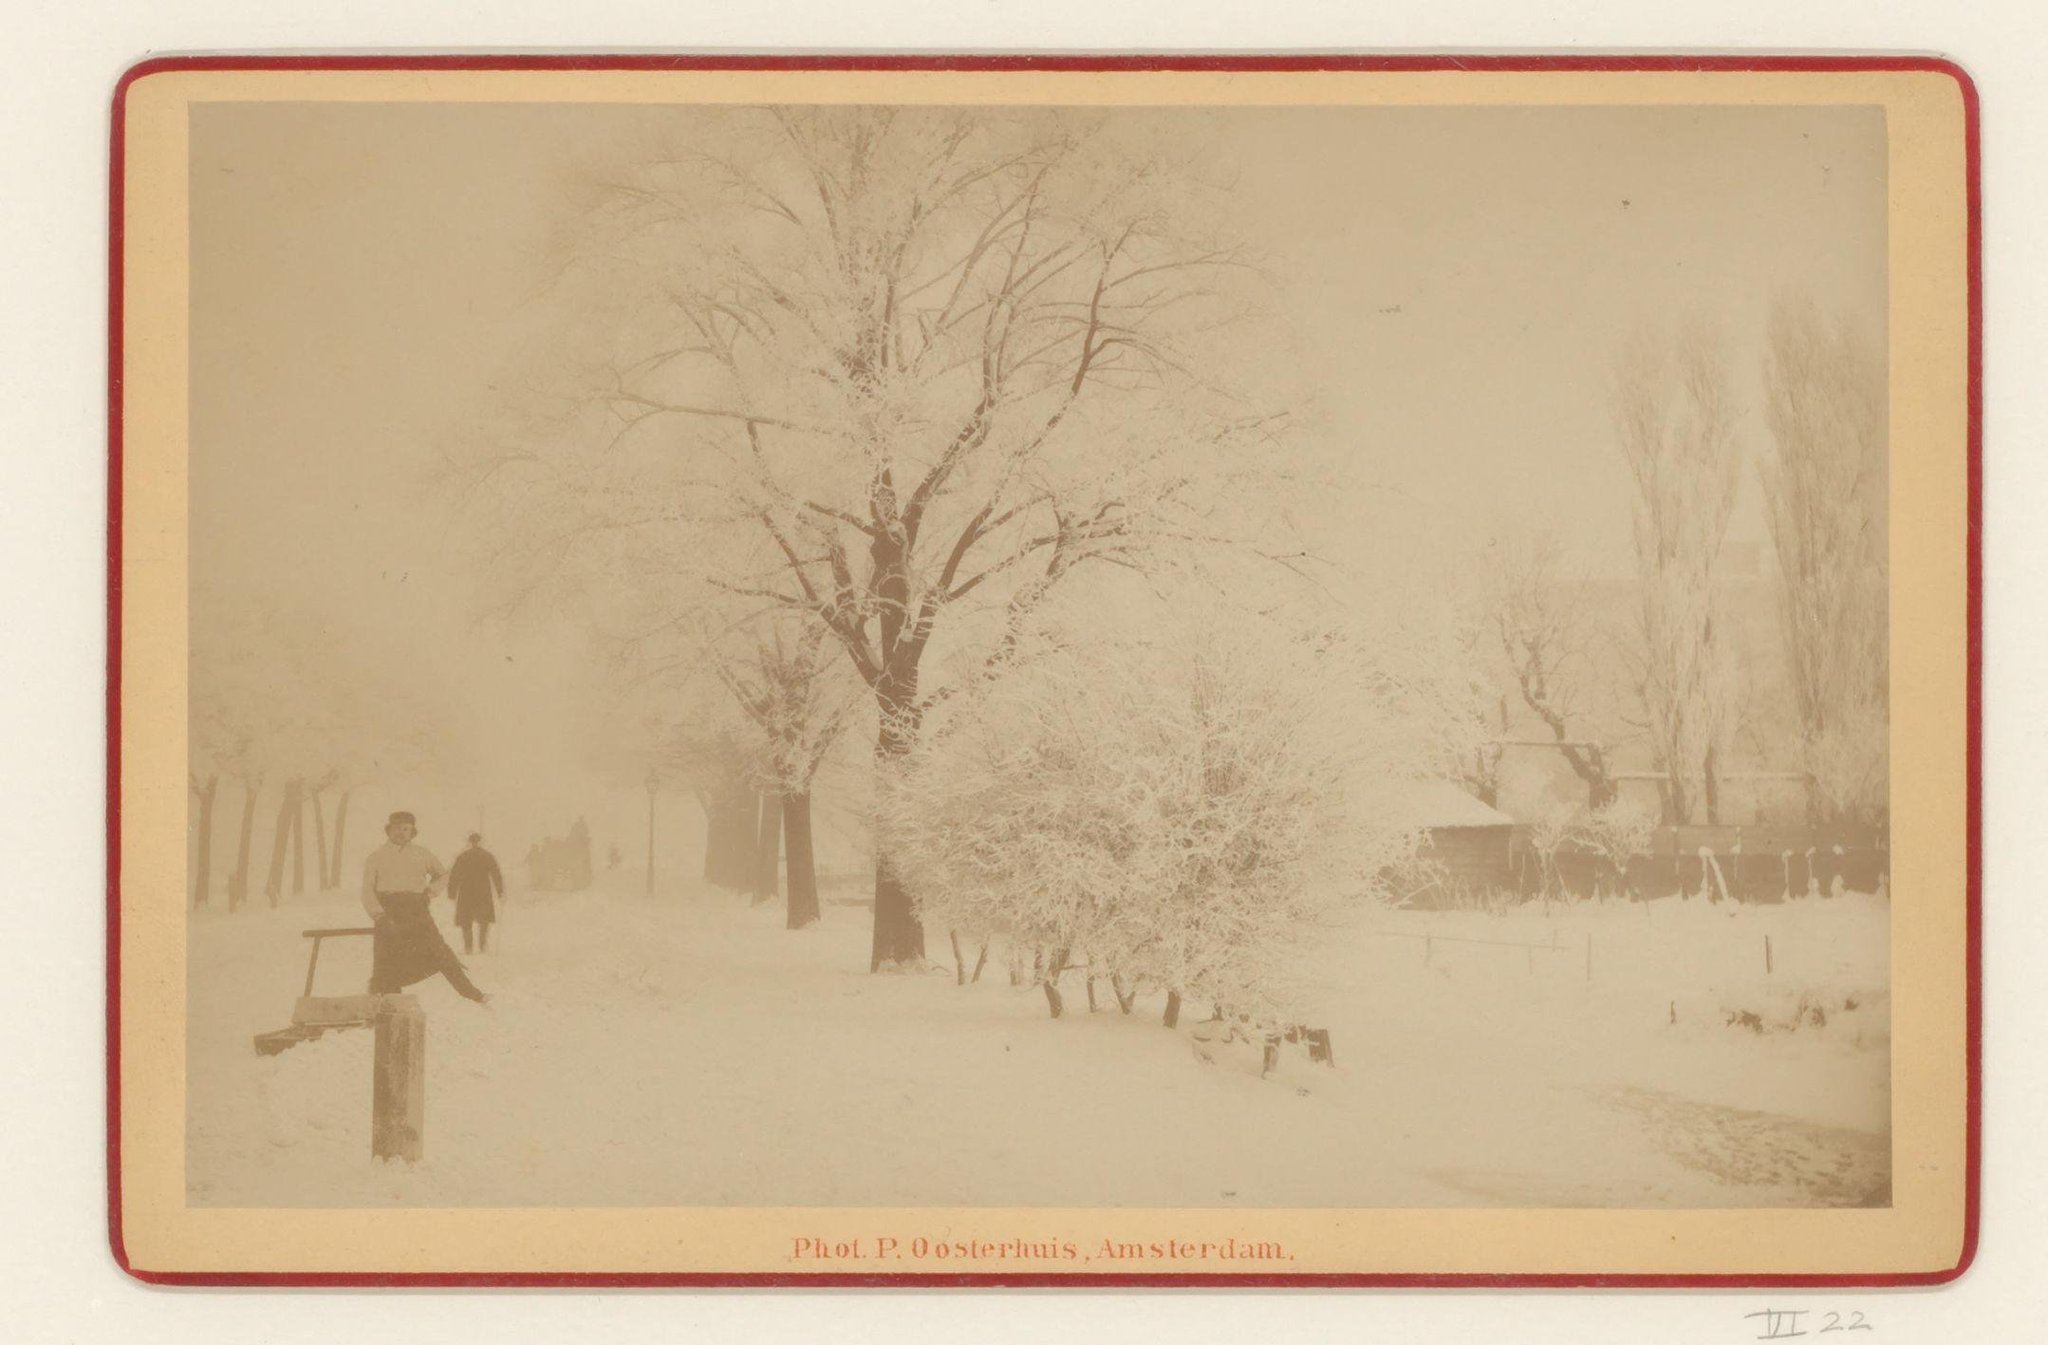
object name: cabinet photograph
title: Gezicht op het Leidsebosje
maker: pieter oosterhuis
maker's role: draughtsman, print maker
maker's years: 1816-1885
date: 1826-1885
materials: cardboard, paper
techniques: albumen print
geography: amsterdam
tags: city-view in general; 'veduta', public gardens, park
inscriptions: collector's mark: ‘6’ Lugt 1641b, inscription: ‘Uit het Leidsche Bosch / naar de ingang van 't / Wandelpark’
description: Onderwerpsrubriek binnen de Atlas Amsterdam: Buitensingel of wel: Gezichten langs en op de Stadsvest van Raampoort tot Zeeburgerdijk.